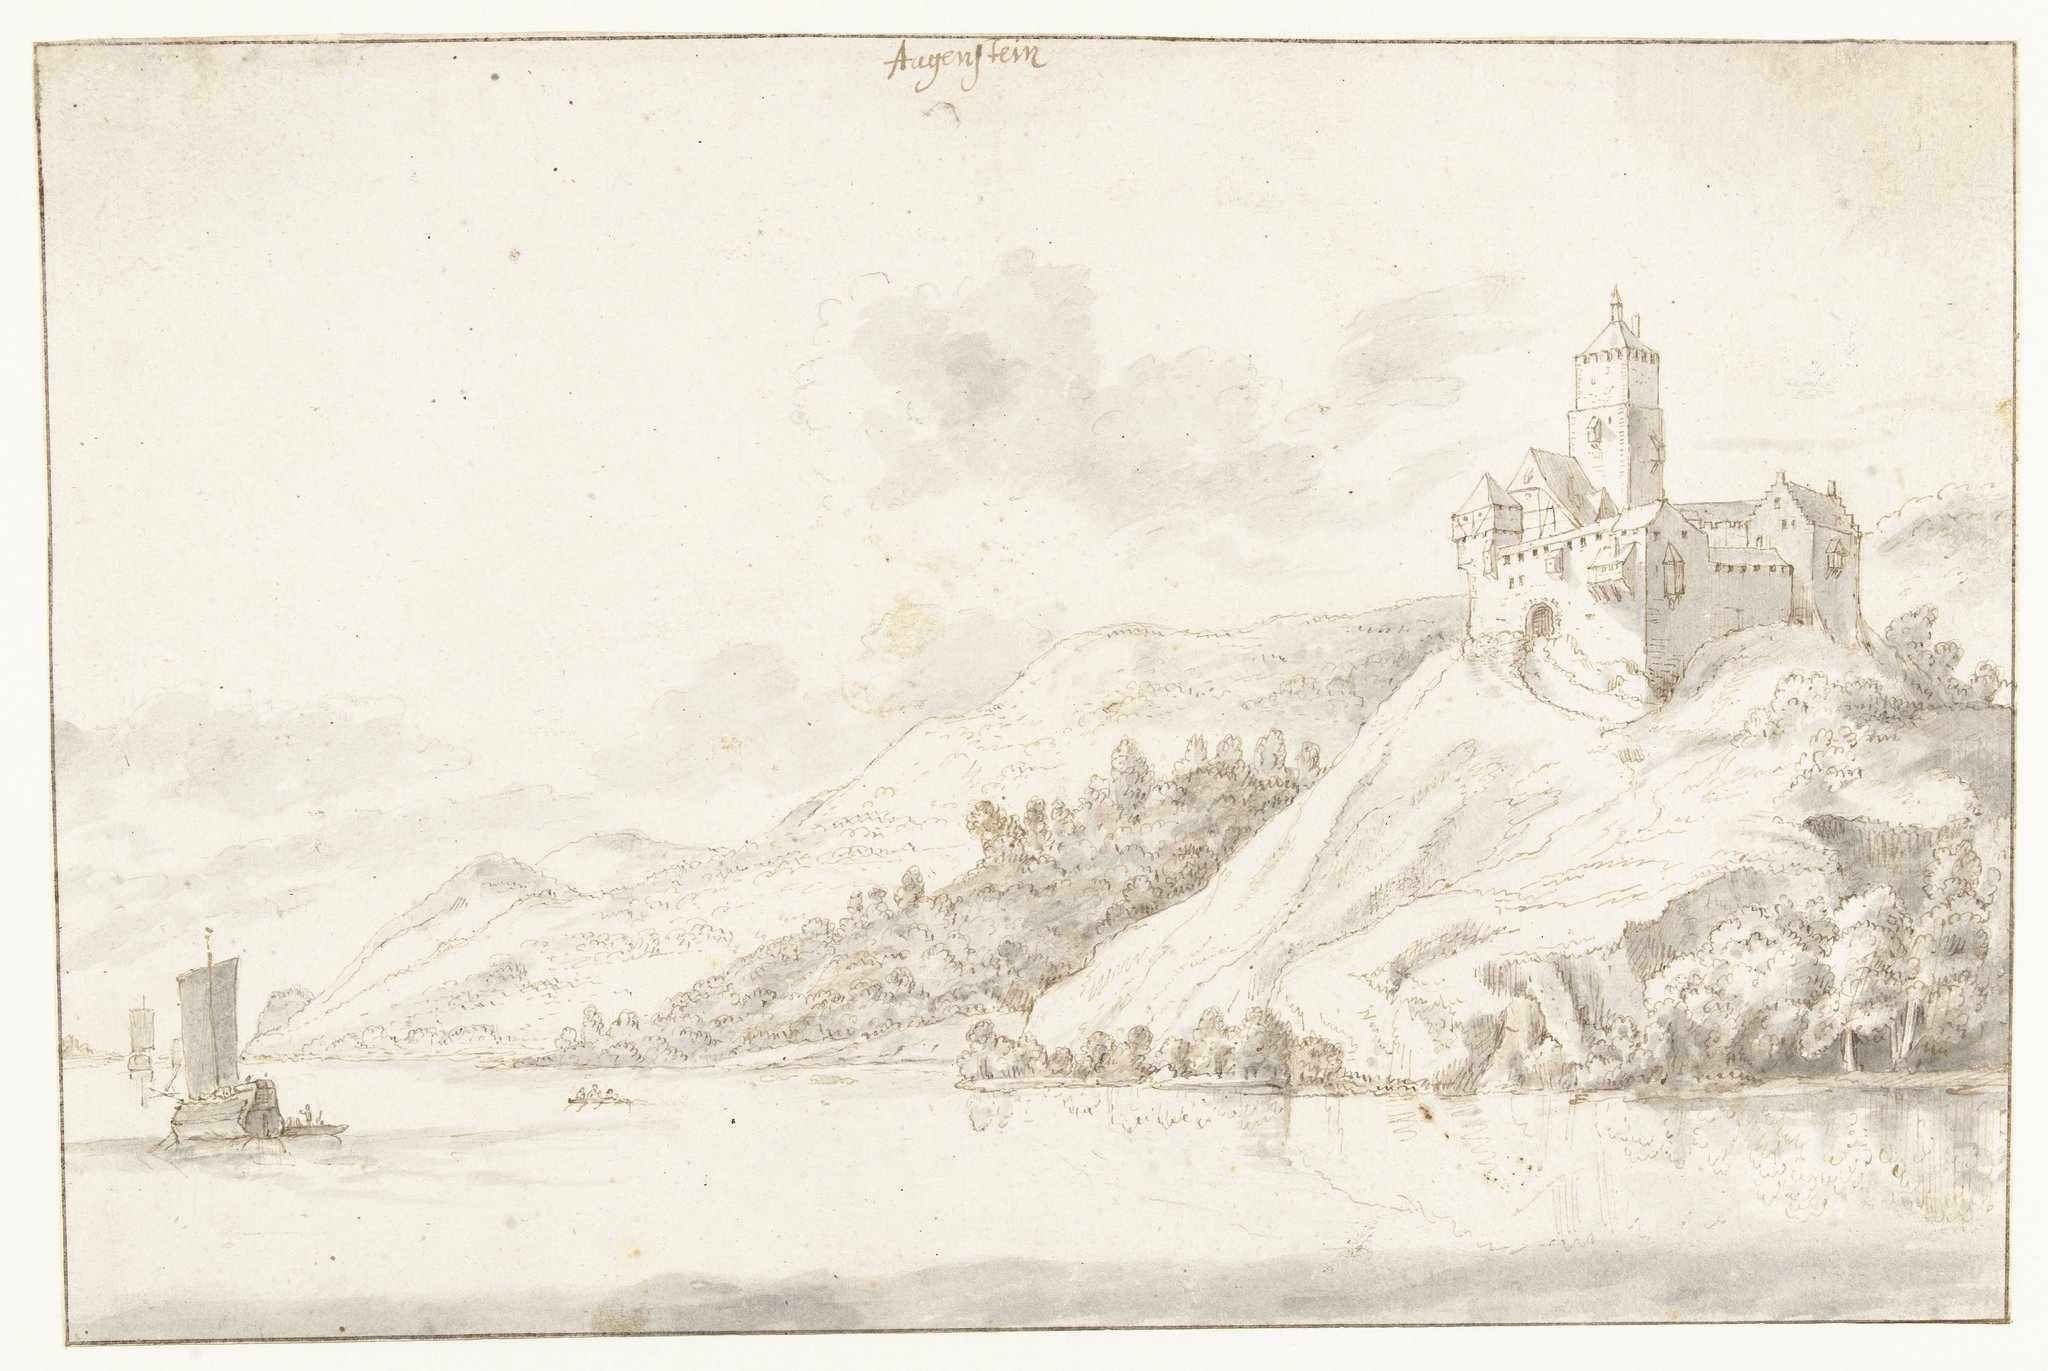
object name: drawing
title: Gezicht op het kasteel Hagenstein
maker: bonaventura peeters (i)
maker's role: draughtsman, painter, print maker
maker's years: 1614-1652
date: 1624-1652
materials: ink, paper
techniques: brush, pen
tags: castle, river, germany